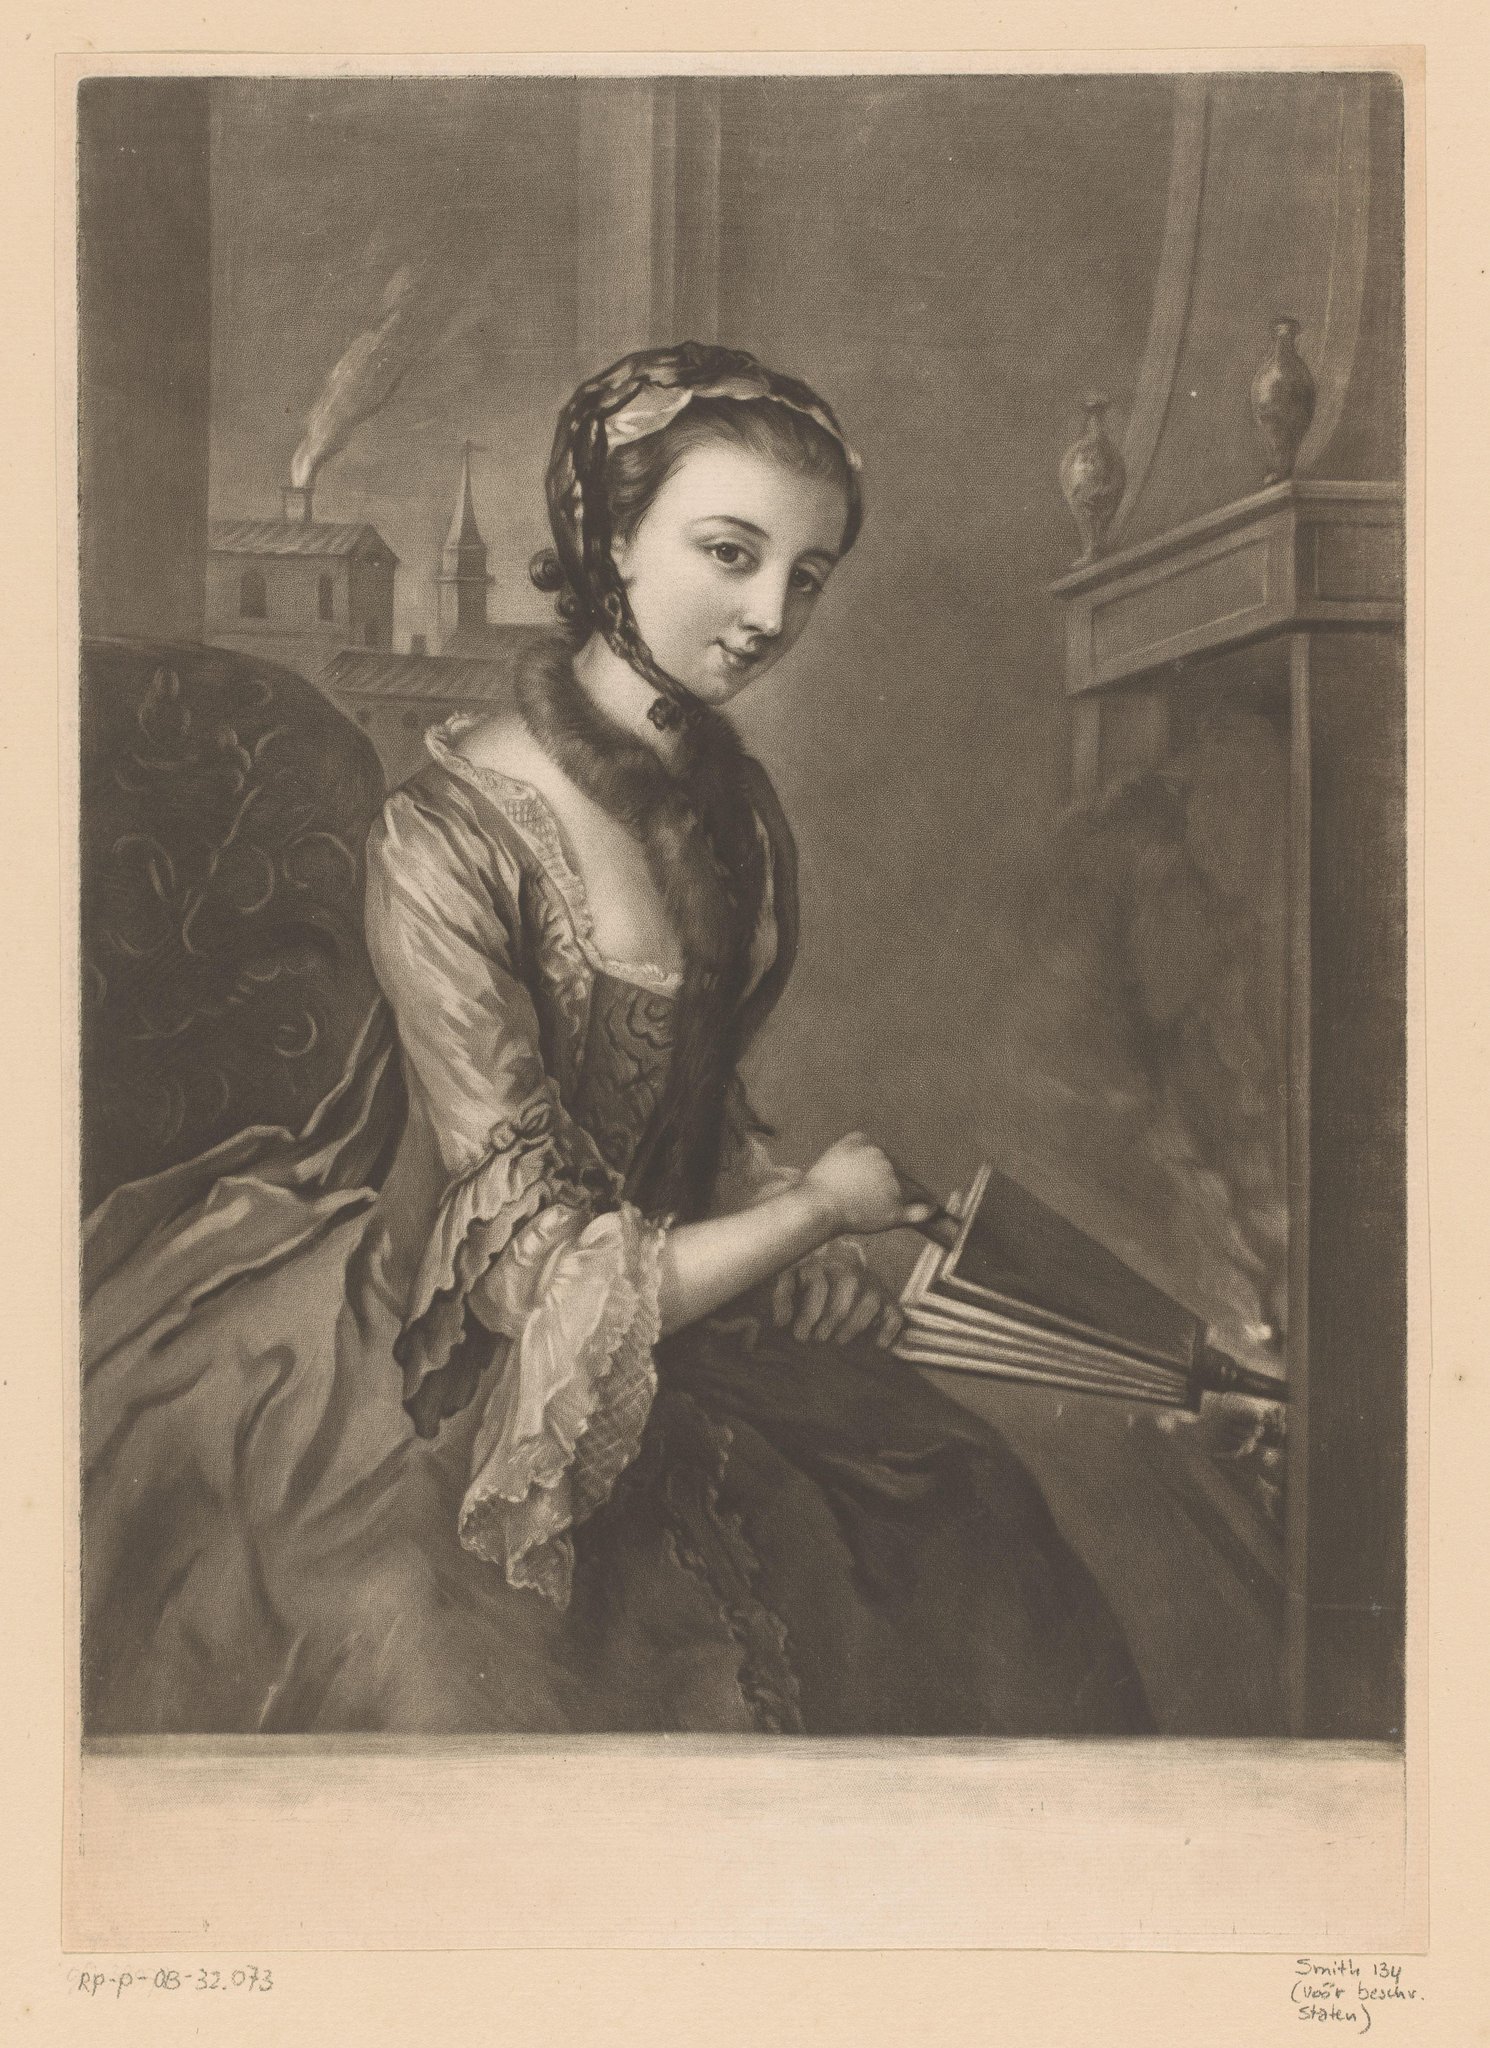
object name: print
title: Jonge vrouw met een blaasbalg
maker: richard houston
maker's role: print maker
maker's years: 1721-1775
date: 1756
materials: paper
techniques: mezzotint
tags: adolescent, young woman, maiden, fire (one of the four elements), bellows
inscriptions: collector's mark: Lugt 240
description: Deze prent maakt deel uit van een serie van vier prenten.